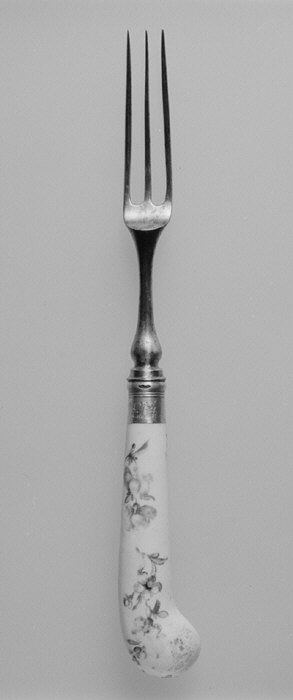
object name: flatware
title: Piece of flatware (from a group of 64 sets)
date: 1801-1900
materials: porcelain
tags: flowers